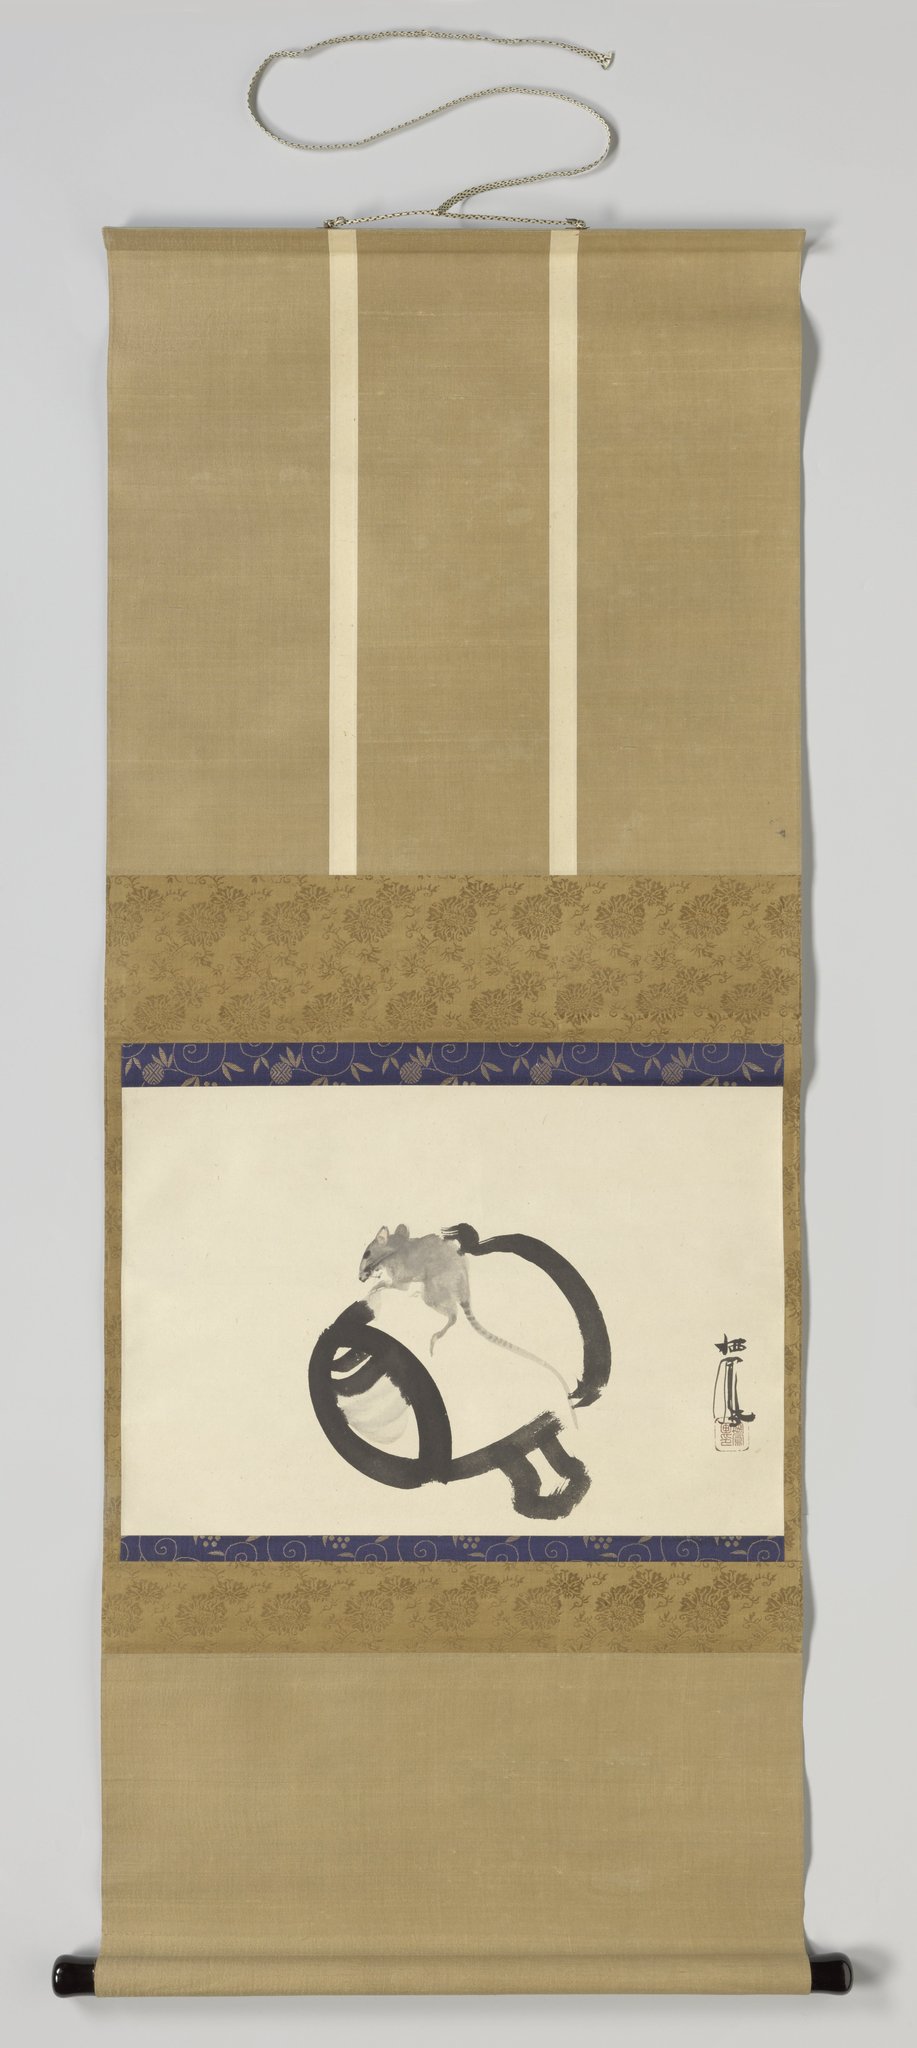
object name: hanging scroll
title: Rat on the Hammer of Daikoku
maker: takeuchi seihô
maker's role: print maker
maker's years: 1864-1942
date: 1874-1942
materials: linen, paper, wood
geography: japan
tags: rodents: rat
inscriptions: seal, signature: ‘Seíhô’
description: The rat is the constant companion of the god of wealth, Daikoku. It is often depicted with the god of good fortune’s attribute, the magical wooden hammer he uses to grant wishes. Seiho created a pleasing contrast between the saturated black and soft grey brushstrokes. These kinds of easily accessible, skilfully painted works were popular with a large audience.